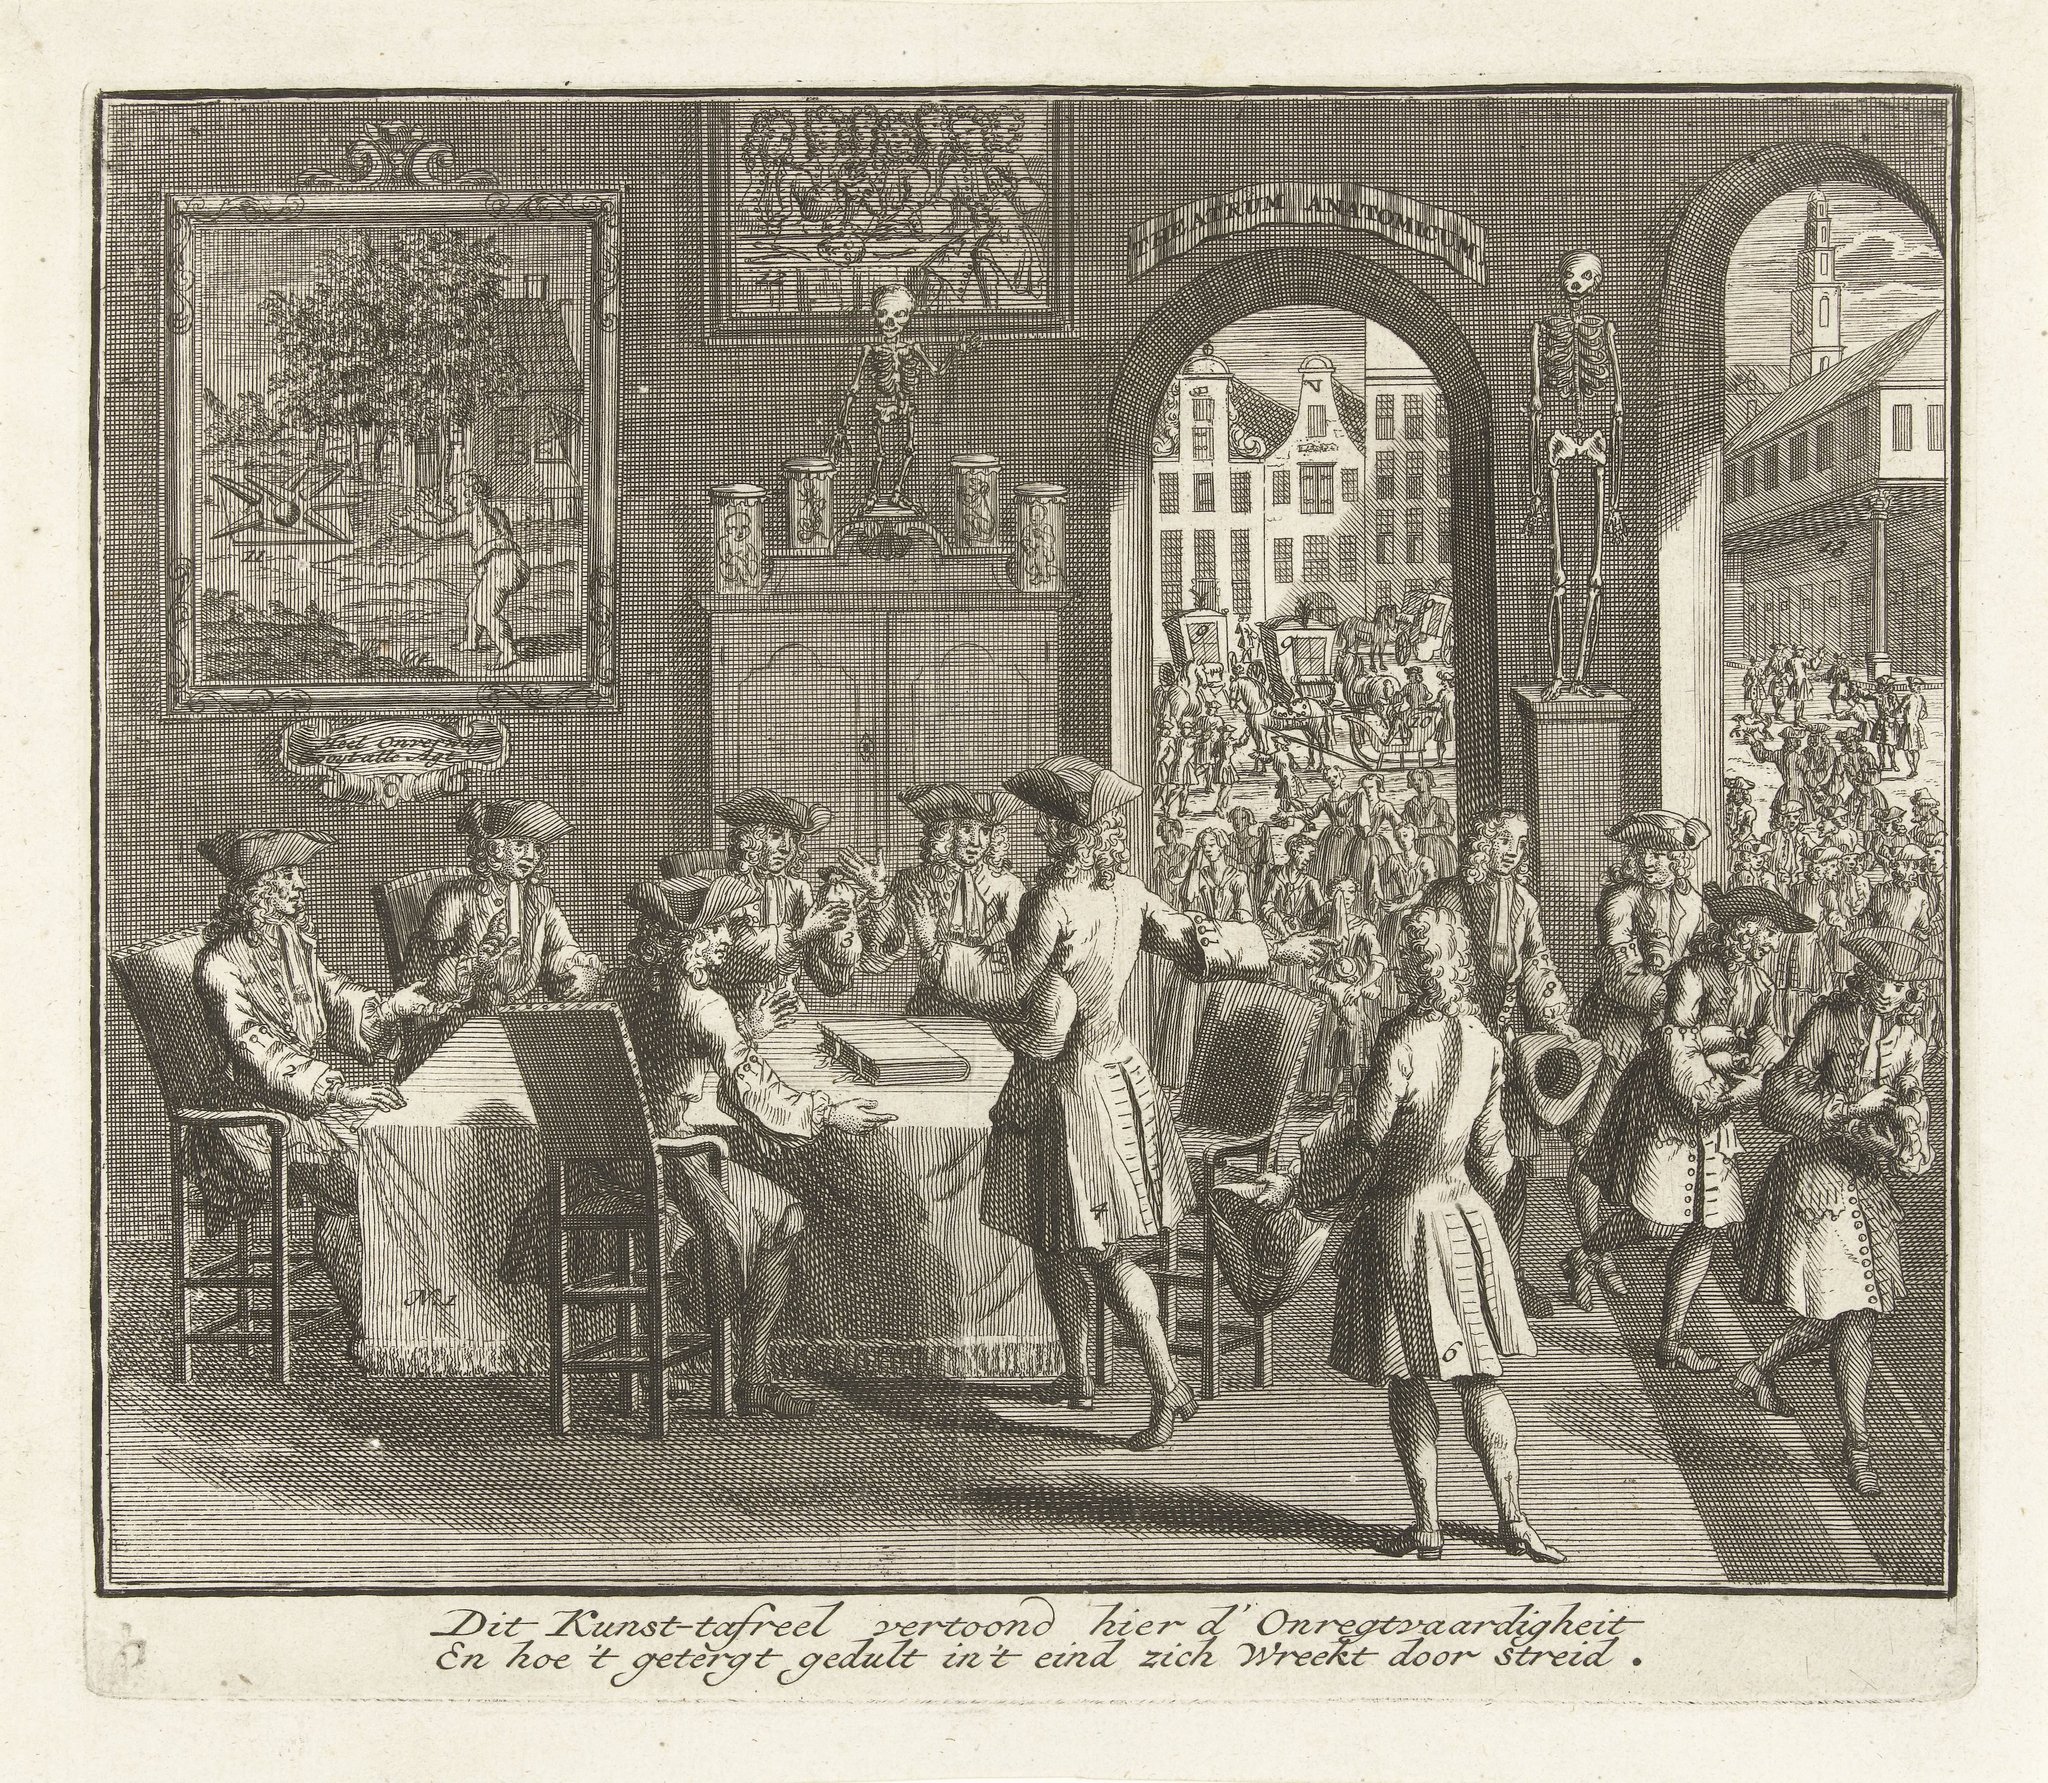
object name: print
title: Allegorie op het afzetten van de acht overlieden van het Chirurgijnsgilde te Amsterdam, 1732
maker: Anonymous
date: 1732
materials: paper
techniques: engraving, etching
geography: northern netherlands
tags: board of a guild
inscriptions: collector's mark: Lugt 2228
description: Allegorie op het afzetten van de acht overlieden van het Chirurgijnsgilde te Amsterdam, 24 januari 1732. Vergadering van de overlieden geleid door Abraham Titsingh in de gildekamer, links lopen drie grijnzende overlieden weg met het geld uit de weduwenkas. Aan de muur enkele allegorische schilderijen, boven de poort: Theatrum Anatomicum. In het onderschrift een tweeregelis vers. Bij de prent behoort een apart gedrukte verklaring van de plaat.